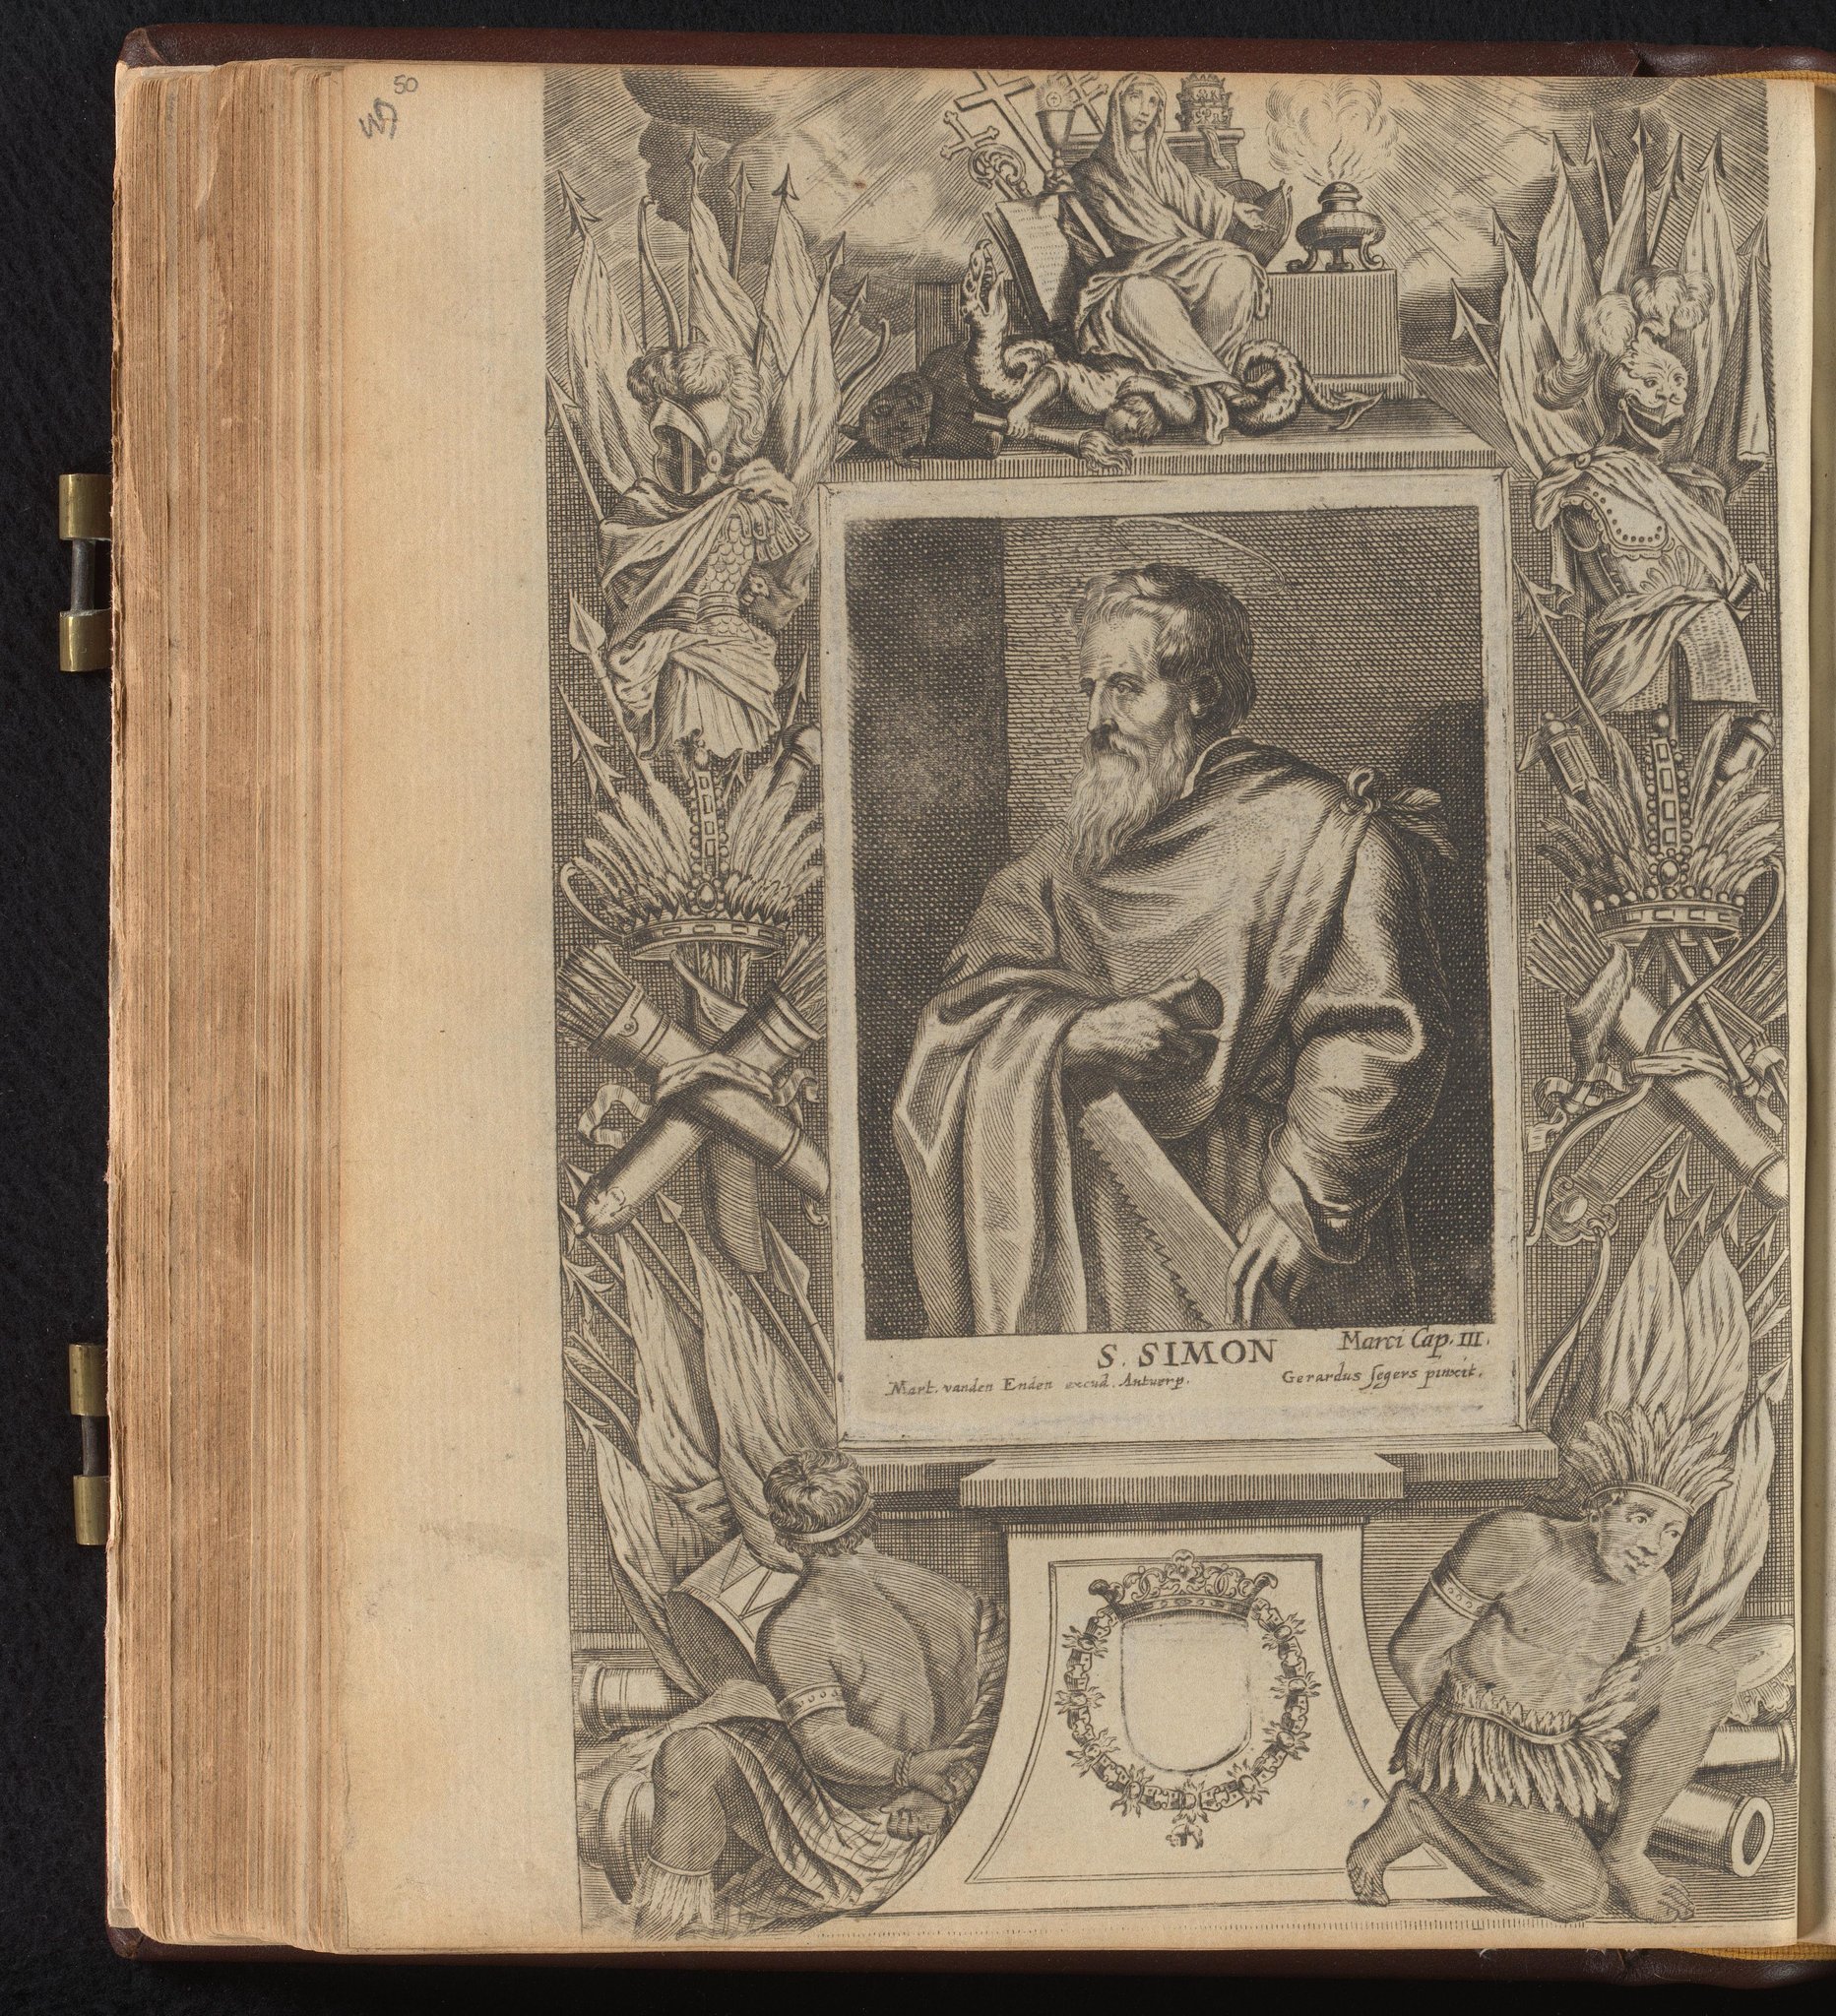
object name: album leaf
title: Heilige Simon Zelotes met zaag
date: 1783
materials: paper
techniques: engraving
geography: southern netherlands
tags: fides (faith) as roman personification, archer's weapons: bow and arrow, the apostle simon zelotes (or simon the canaanite); possible attributes: book, saw, scroll, armour, indigenous peoples of north america, armorial bearing, heraldry, smoking pot as symbol of 'vanitas'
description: Prent maakt deel uit van een prentbijbel.